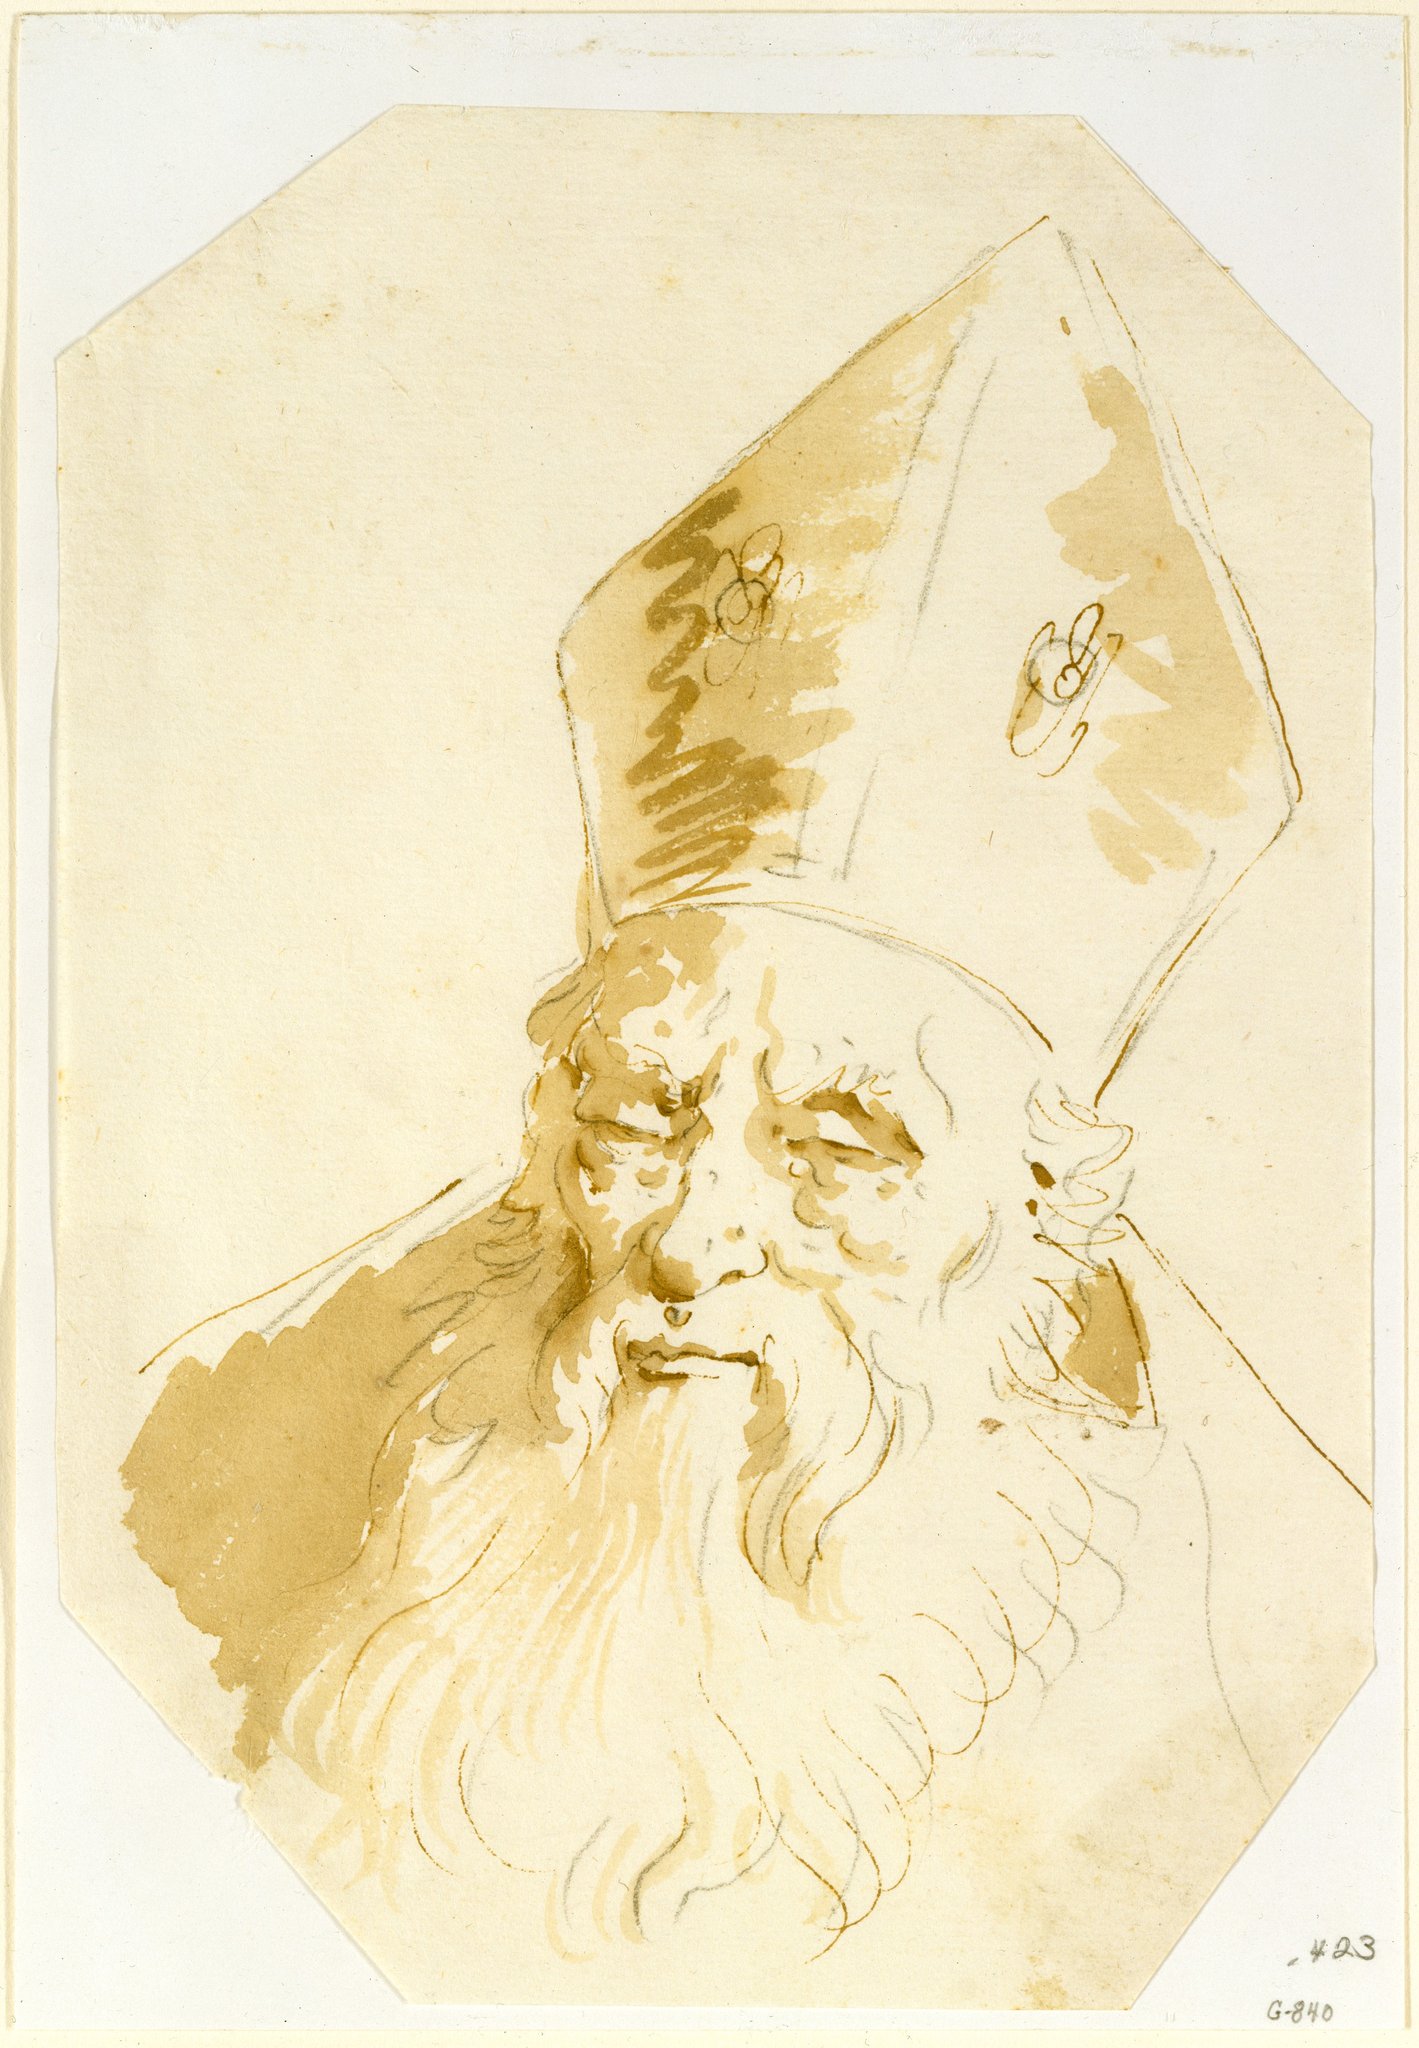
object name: drawing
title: Head of a Bishop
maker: giovanni battista tiepolo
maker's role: artist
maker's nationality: italian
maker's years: 1696-1770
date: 1742-1757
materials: chalk, ink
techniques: pen, wash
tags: men,bishops